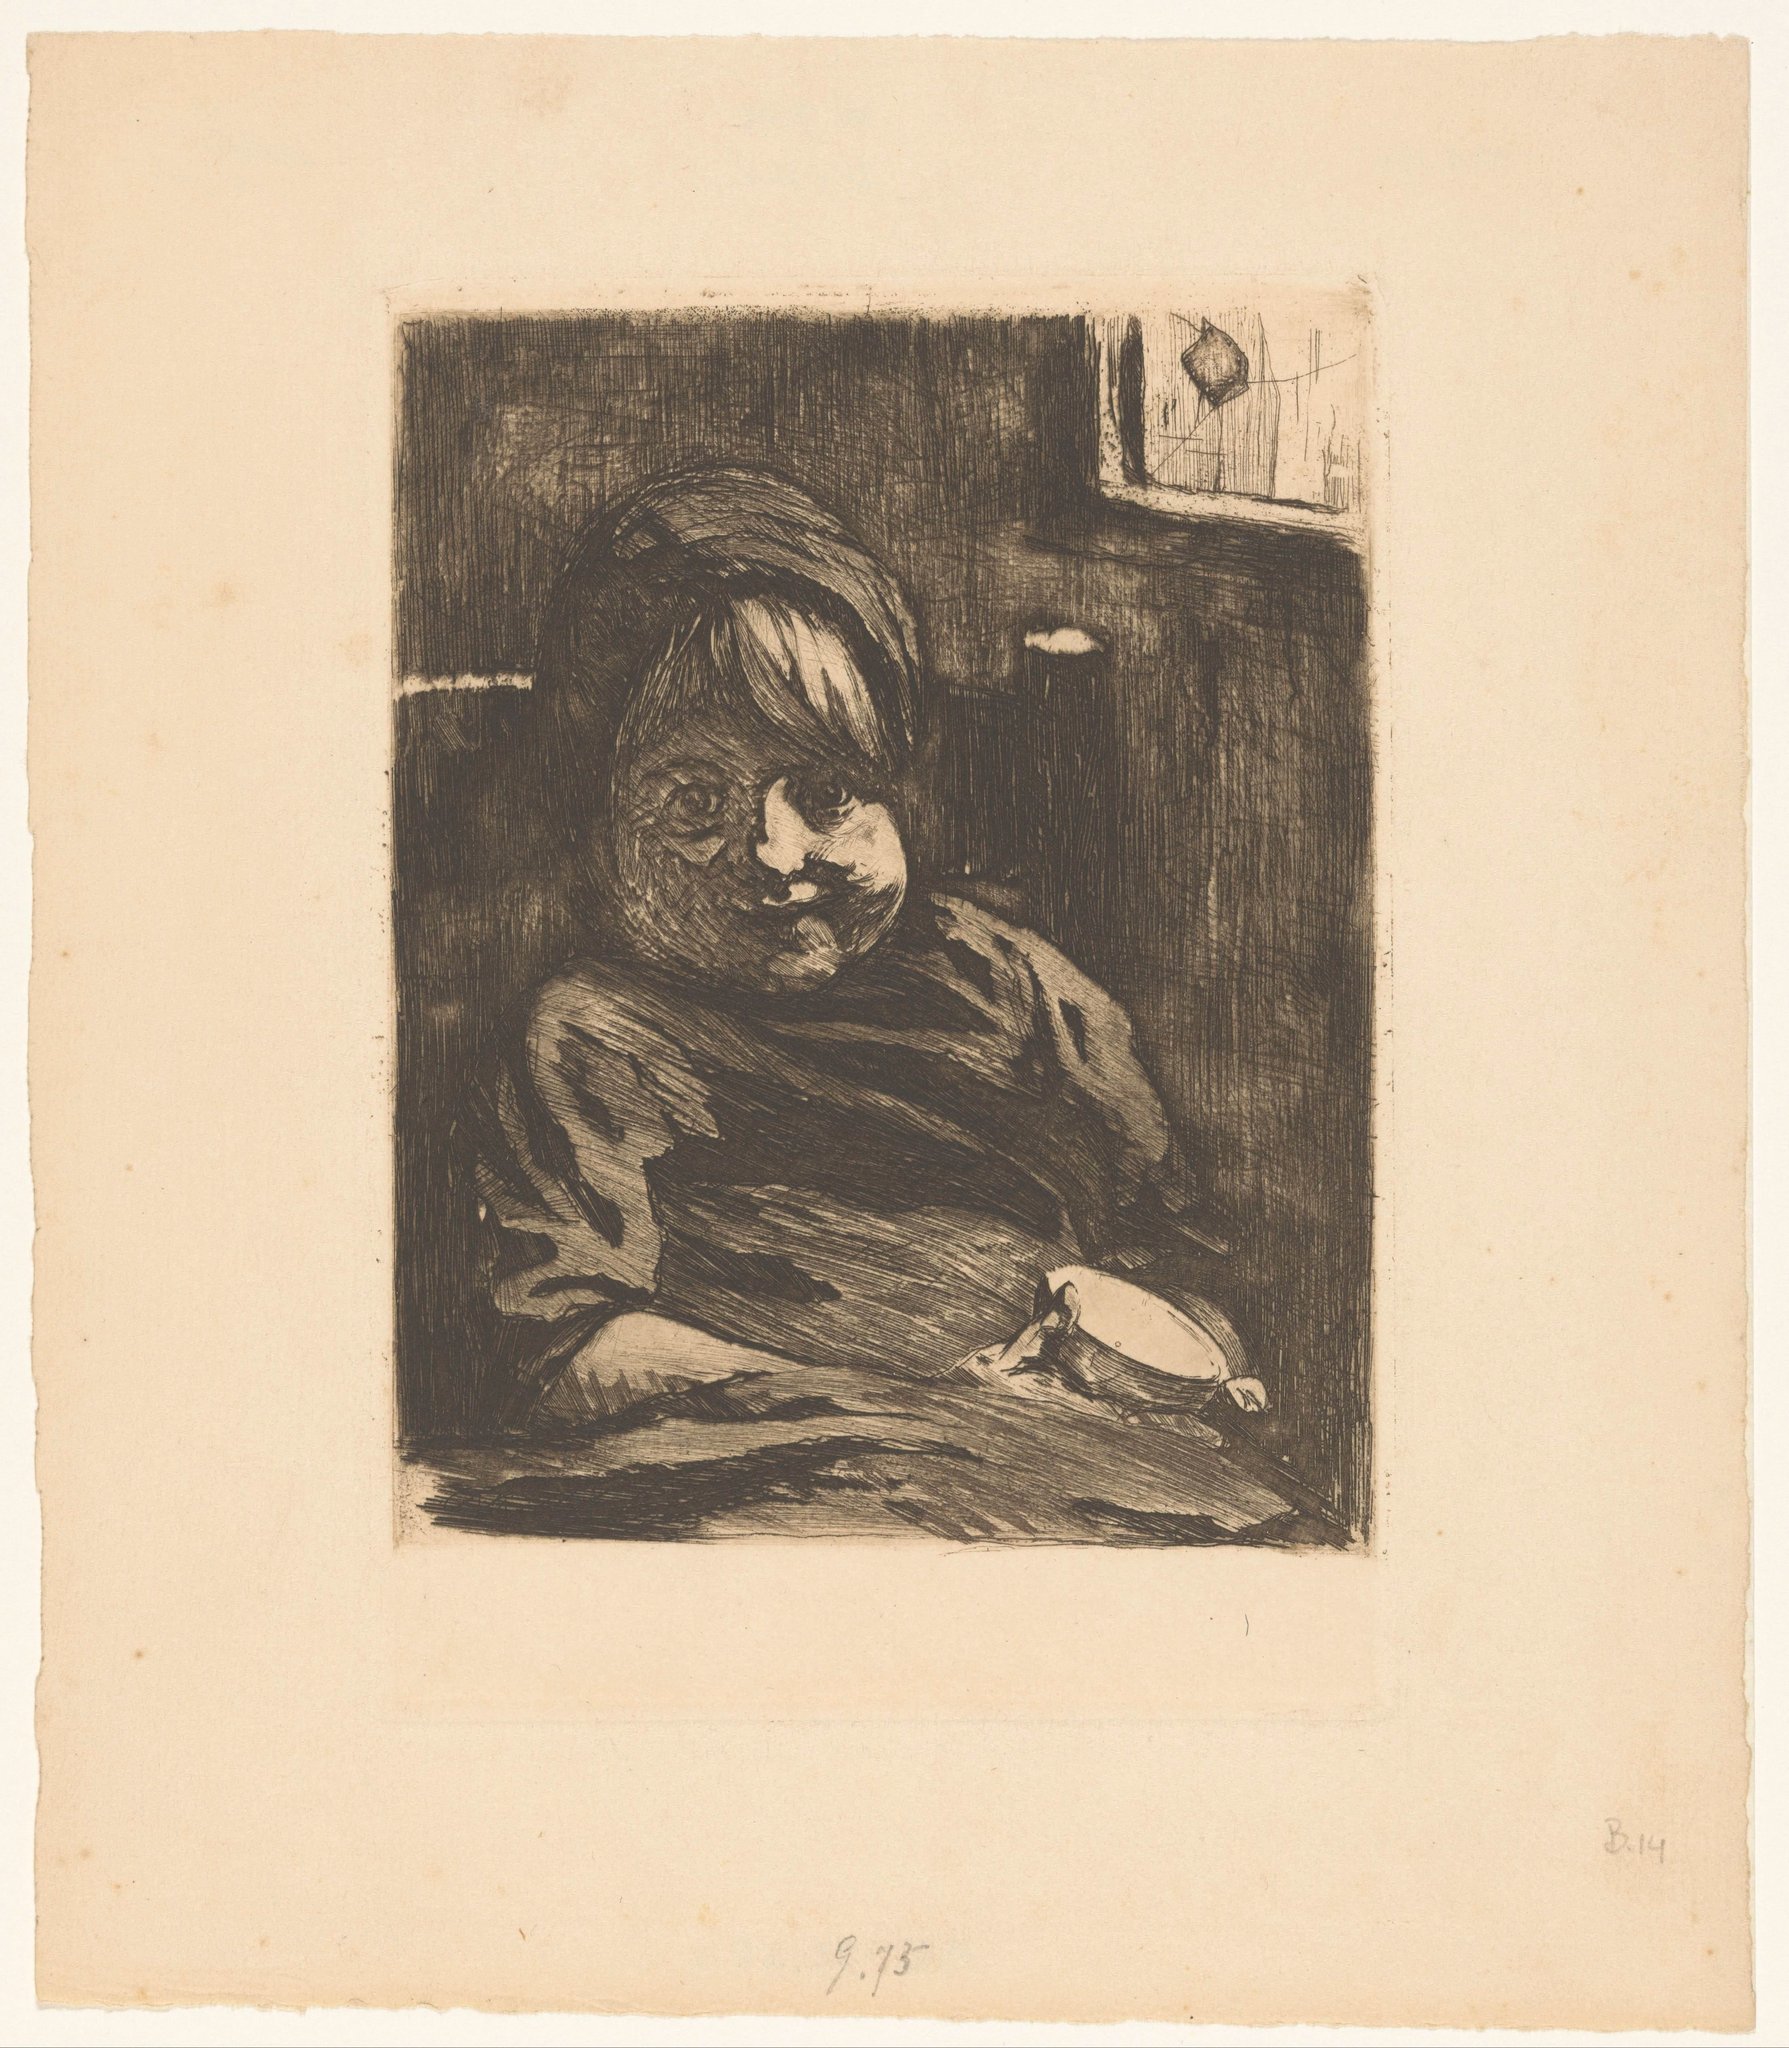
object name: print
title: Zittend kind met een nap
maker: willem witsen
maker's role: draughtsman, painter, print maker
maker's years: 1860-1923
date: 1885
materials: paper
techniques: etching, intaglio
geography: ewijkshoeve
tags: child, cup, chair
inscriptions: watermark: ‘[...]an Gelder Zonen / Holland’